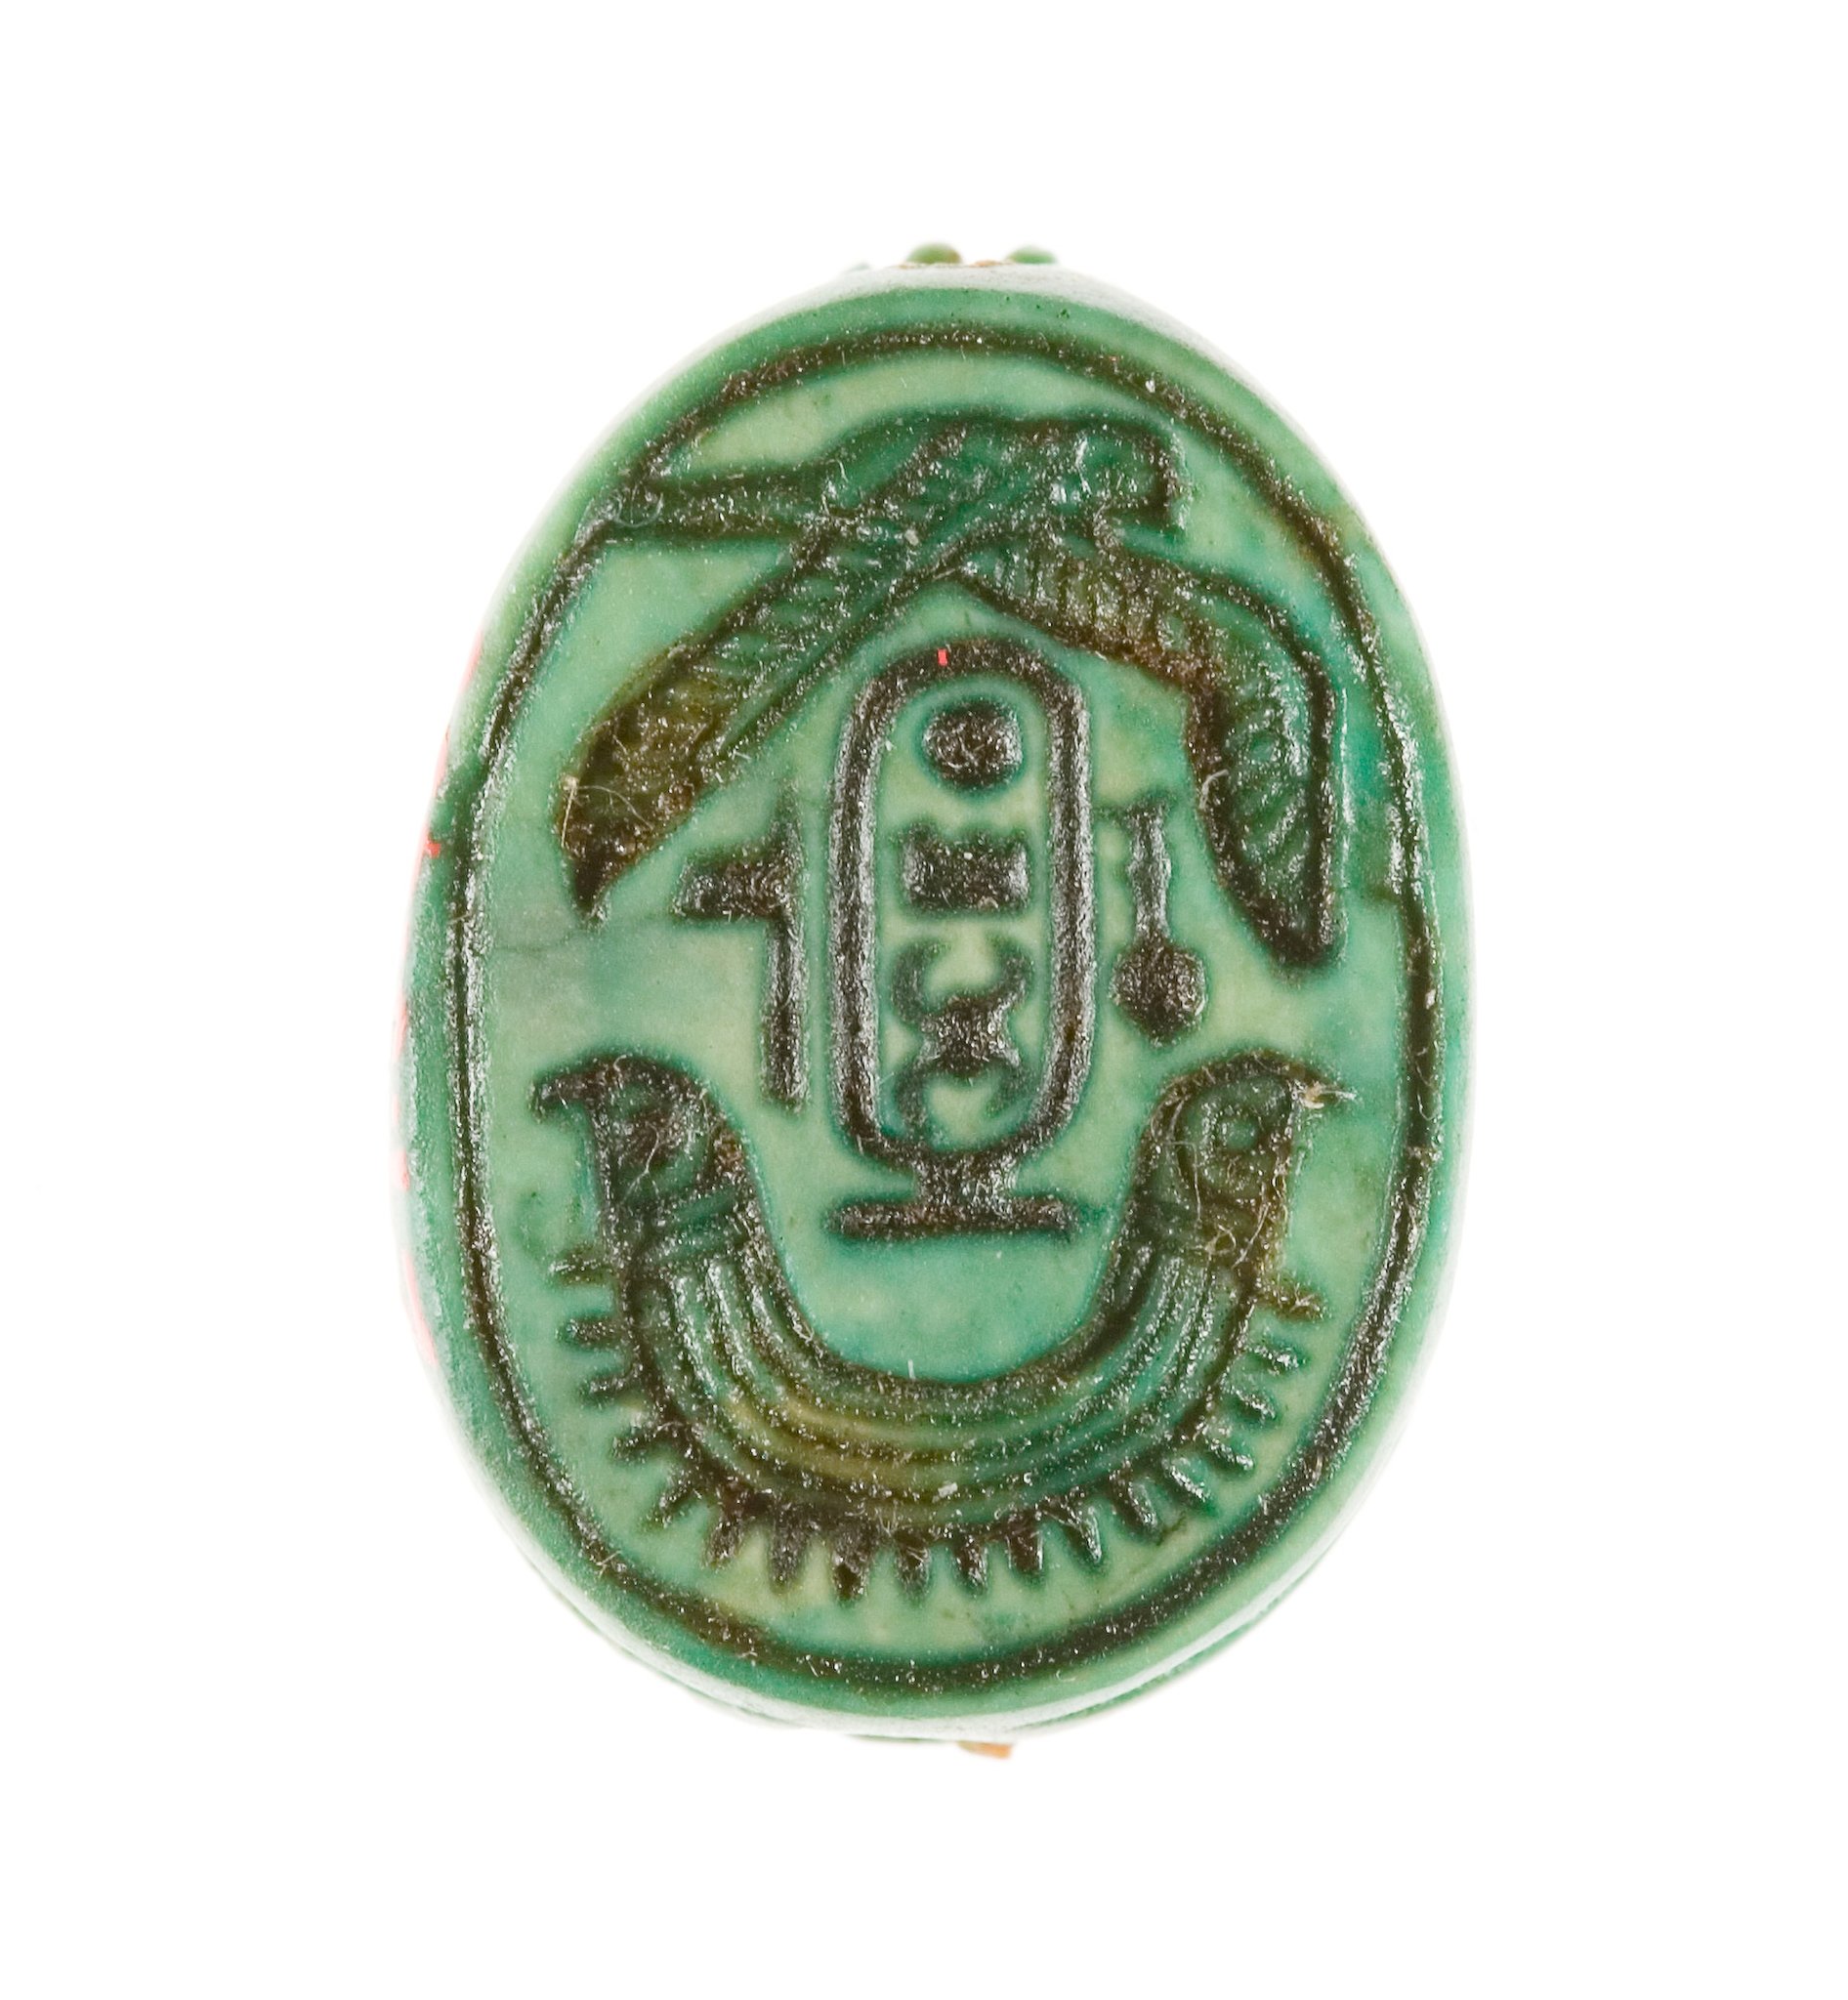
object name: scarab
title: Scarab Inscribed with the Throne Name of Thutmose III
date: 1479-1458 BCE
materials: stone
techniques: glazing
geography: egypt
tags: hieroglyphs,scarabs